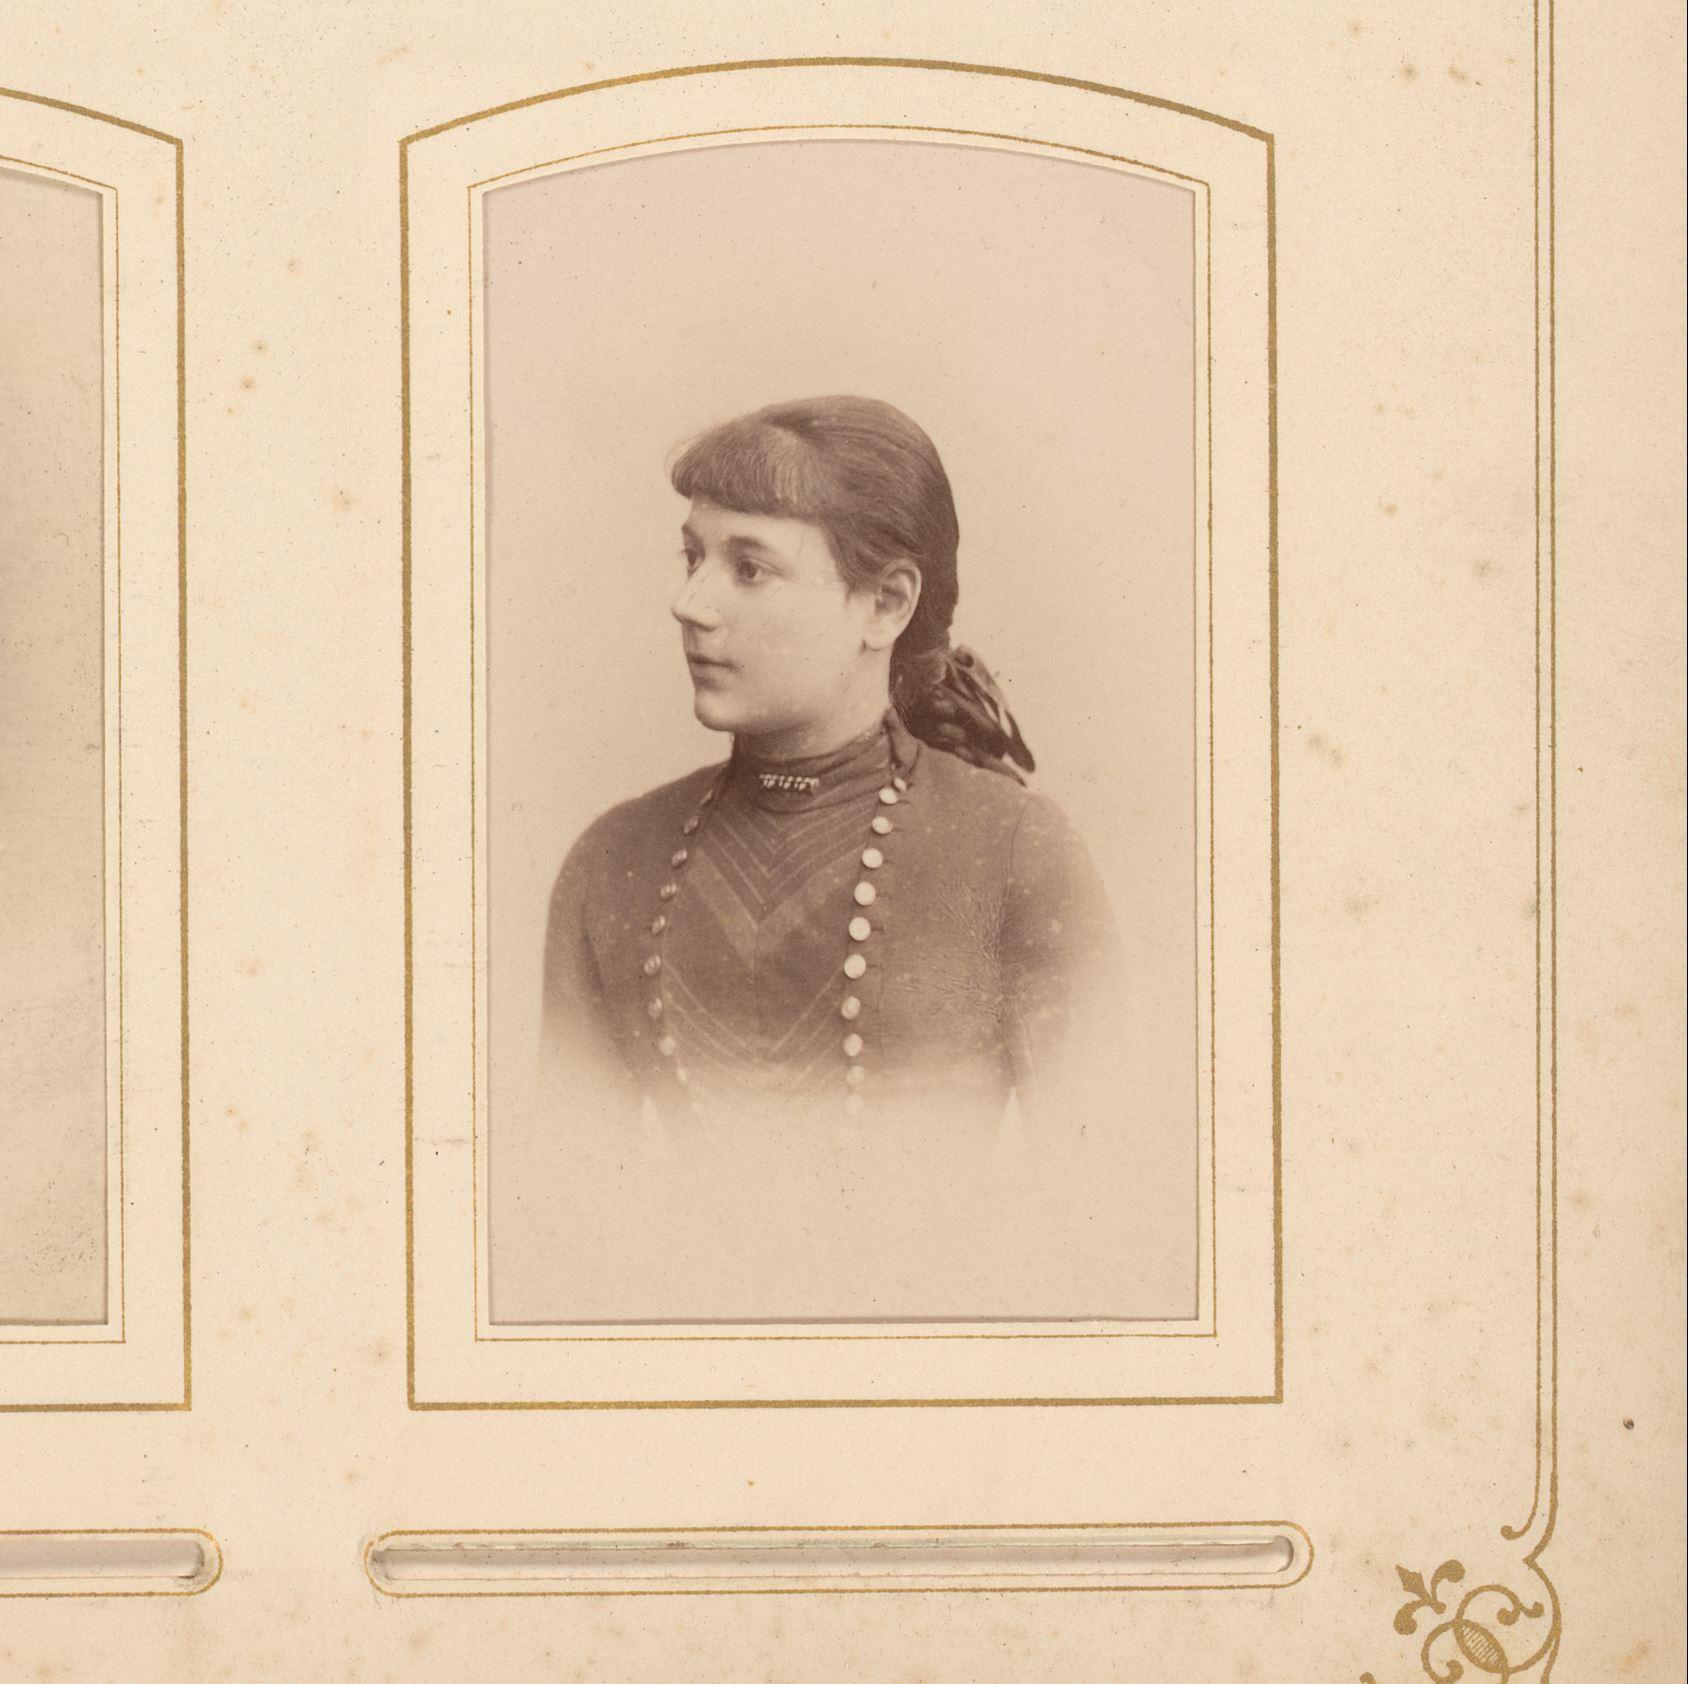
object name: carte de visite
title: Portret van een jonge vrouw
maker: louis oskar grienwaldt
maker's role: fotograaf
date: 1889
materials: cardboard, photographic support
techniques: albumen print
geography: bremen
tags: adolescent, young woman, maiden, historical persons - bb - woman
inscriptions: inscription: ‘L.O.GRIENWALDT/ Photograph. Jnstitut/ BREMEN/ WALL 86./ (...)/ Prämiirt:/ Hannover, Melbourne, Hamburg,/ Nürnberg, Utrecht,/ Eisenach.’, annotation: ‘[...] 1889./ T[..]ter, [...]ma 1889’